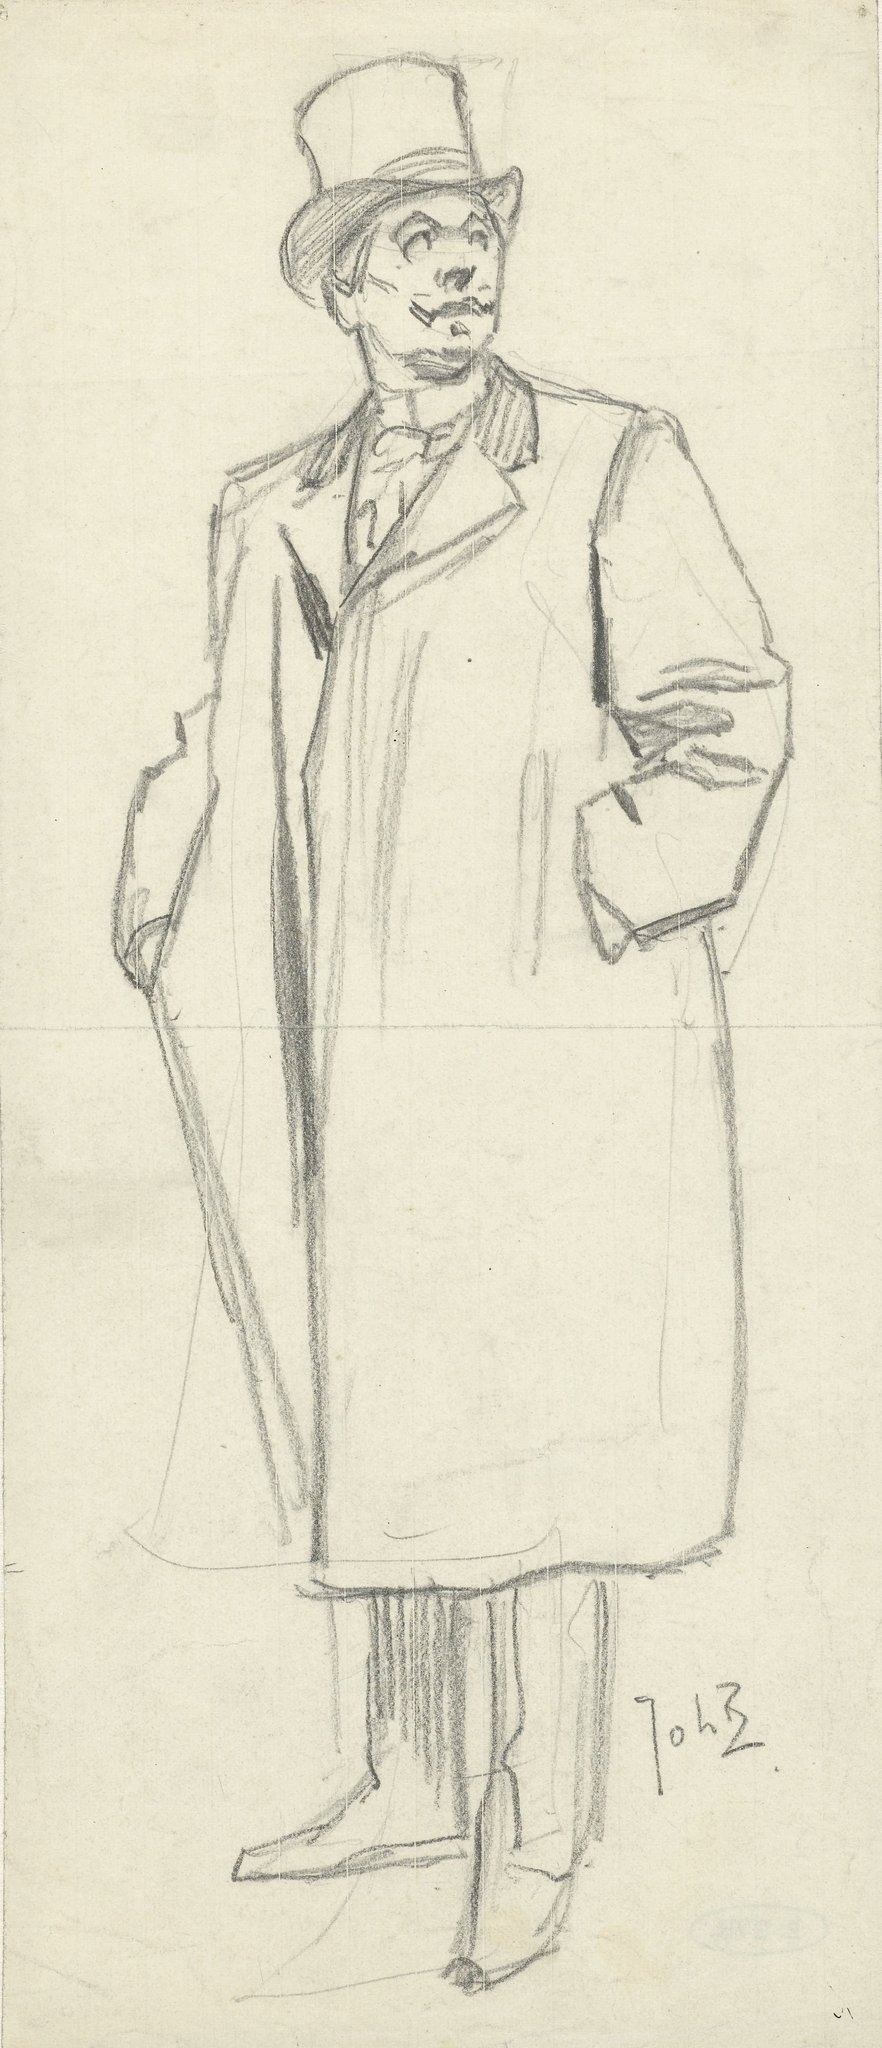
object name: design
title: Staande man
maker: johan braakensiek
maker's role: draughtsman, print maker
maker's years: 1858-1940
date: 1868-1940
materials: paper, pencil